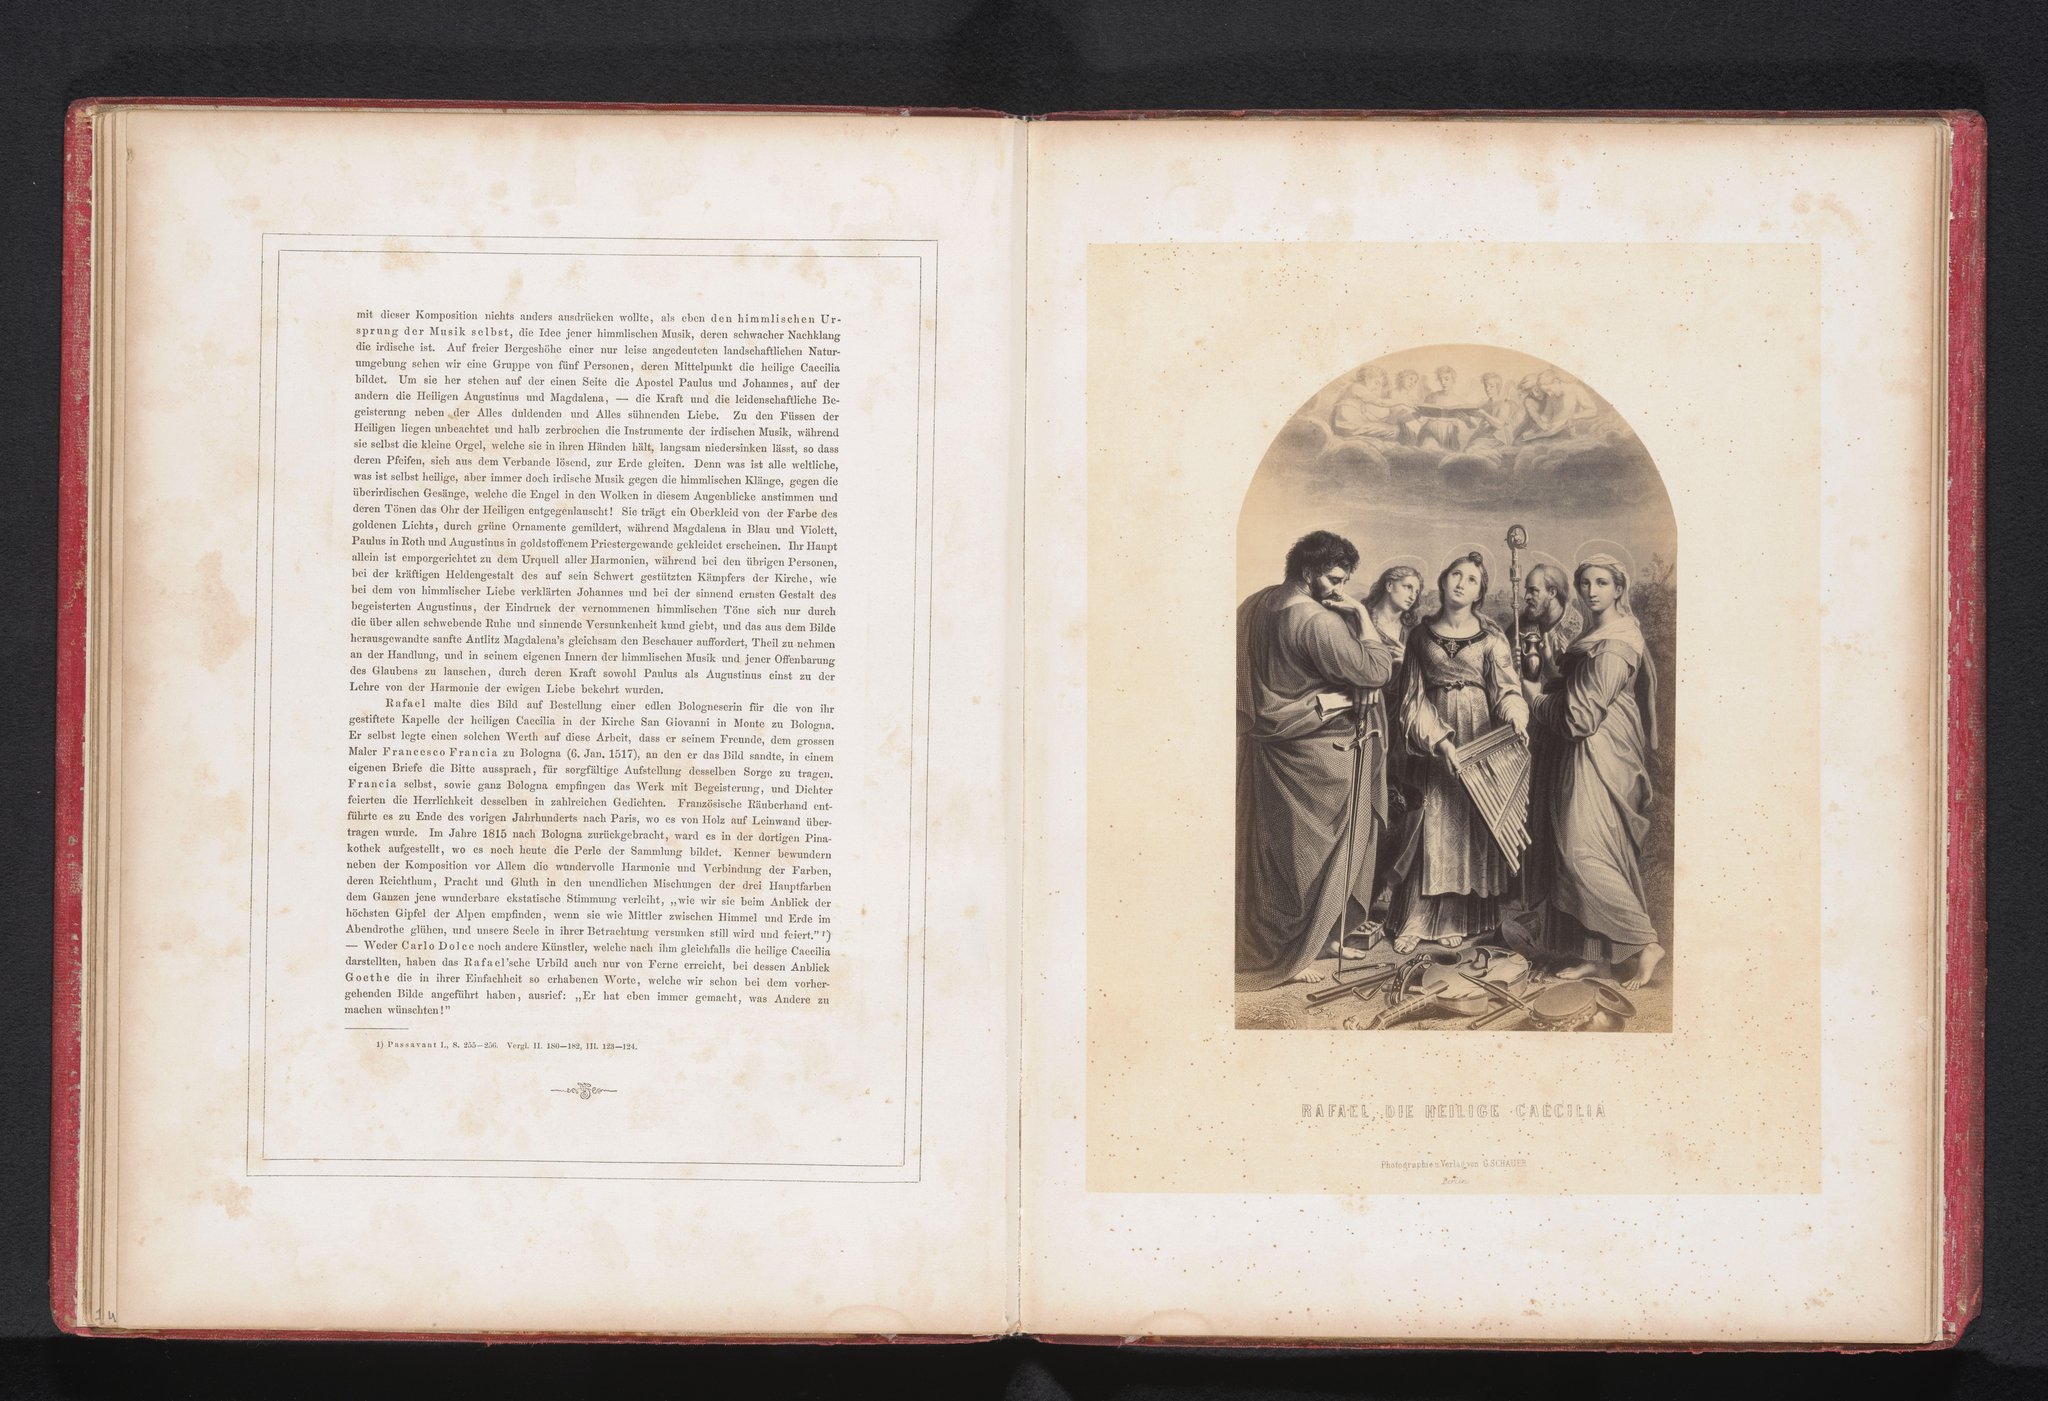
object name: page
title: Rafael, Die heilige Caecilia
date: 1851-1861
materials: photographic support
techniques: albumen print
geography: berlin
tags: the virgin martyr cecilia of rome; possible attributes: falcon, musical instruments, organ, wreath of roses and lilies